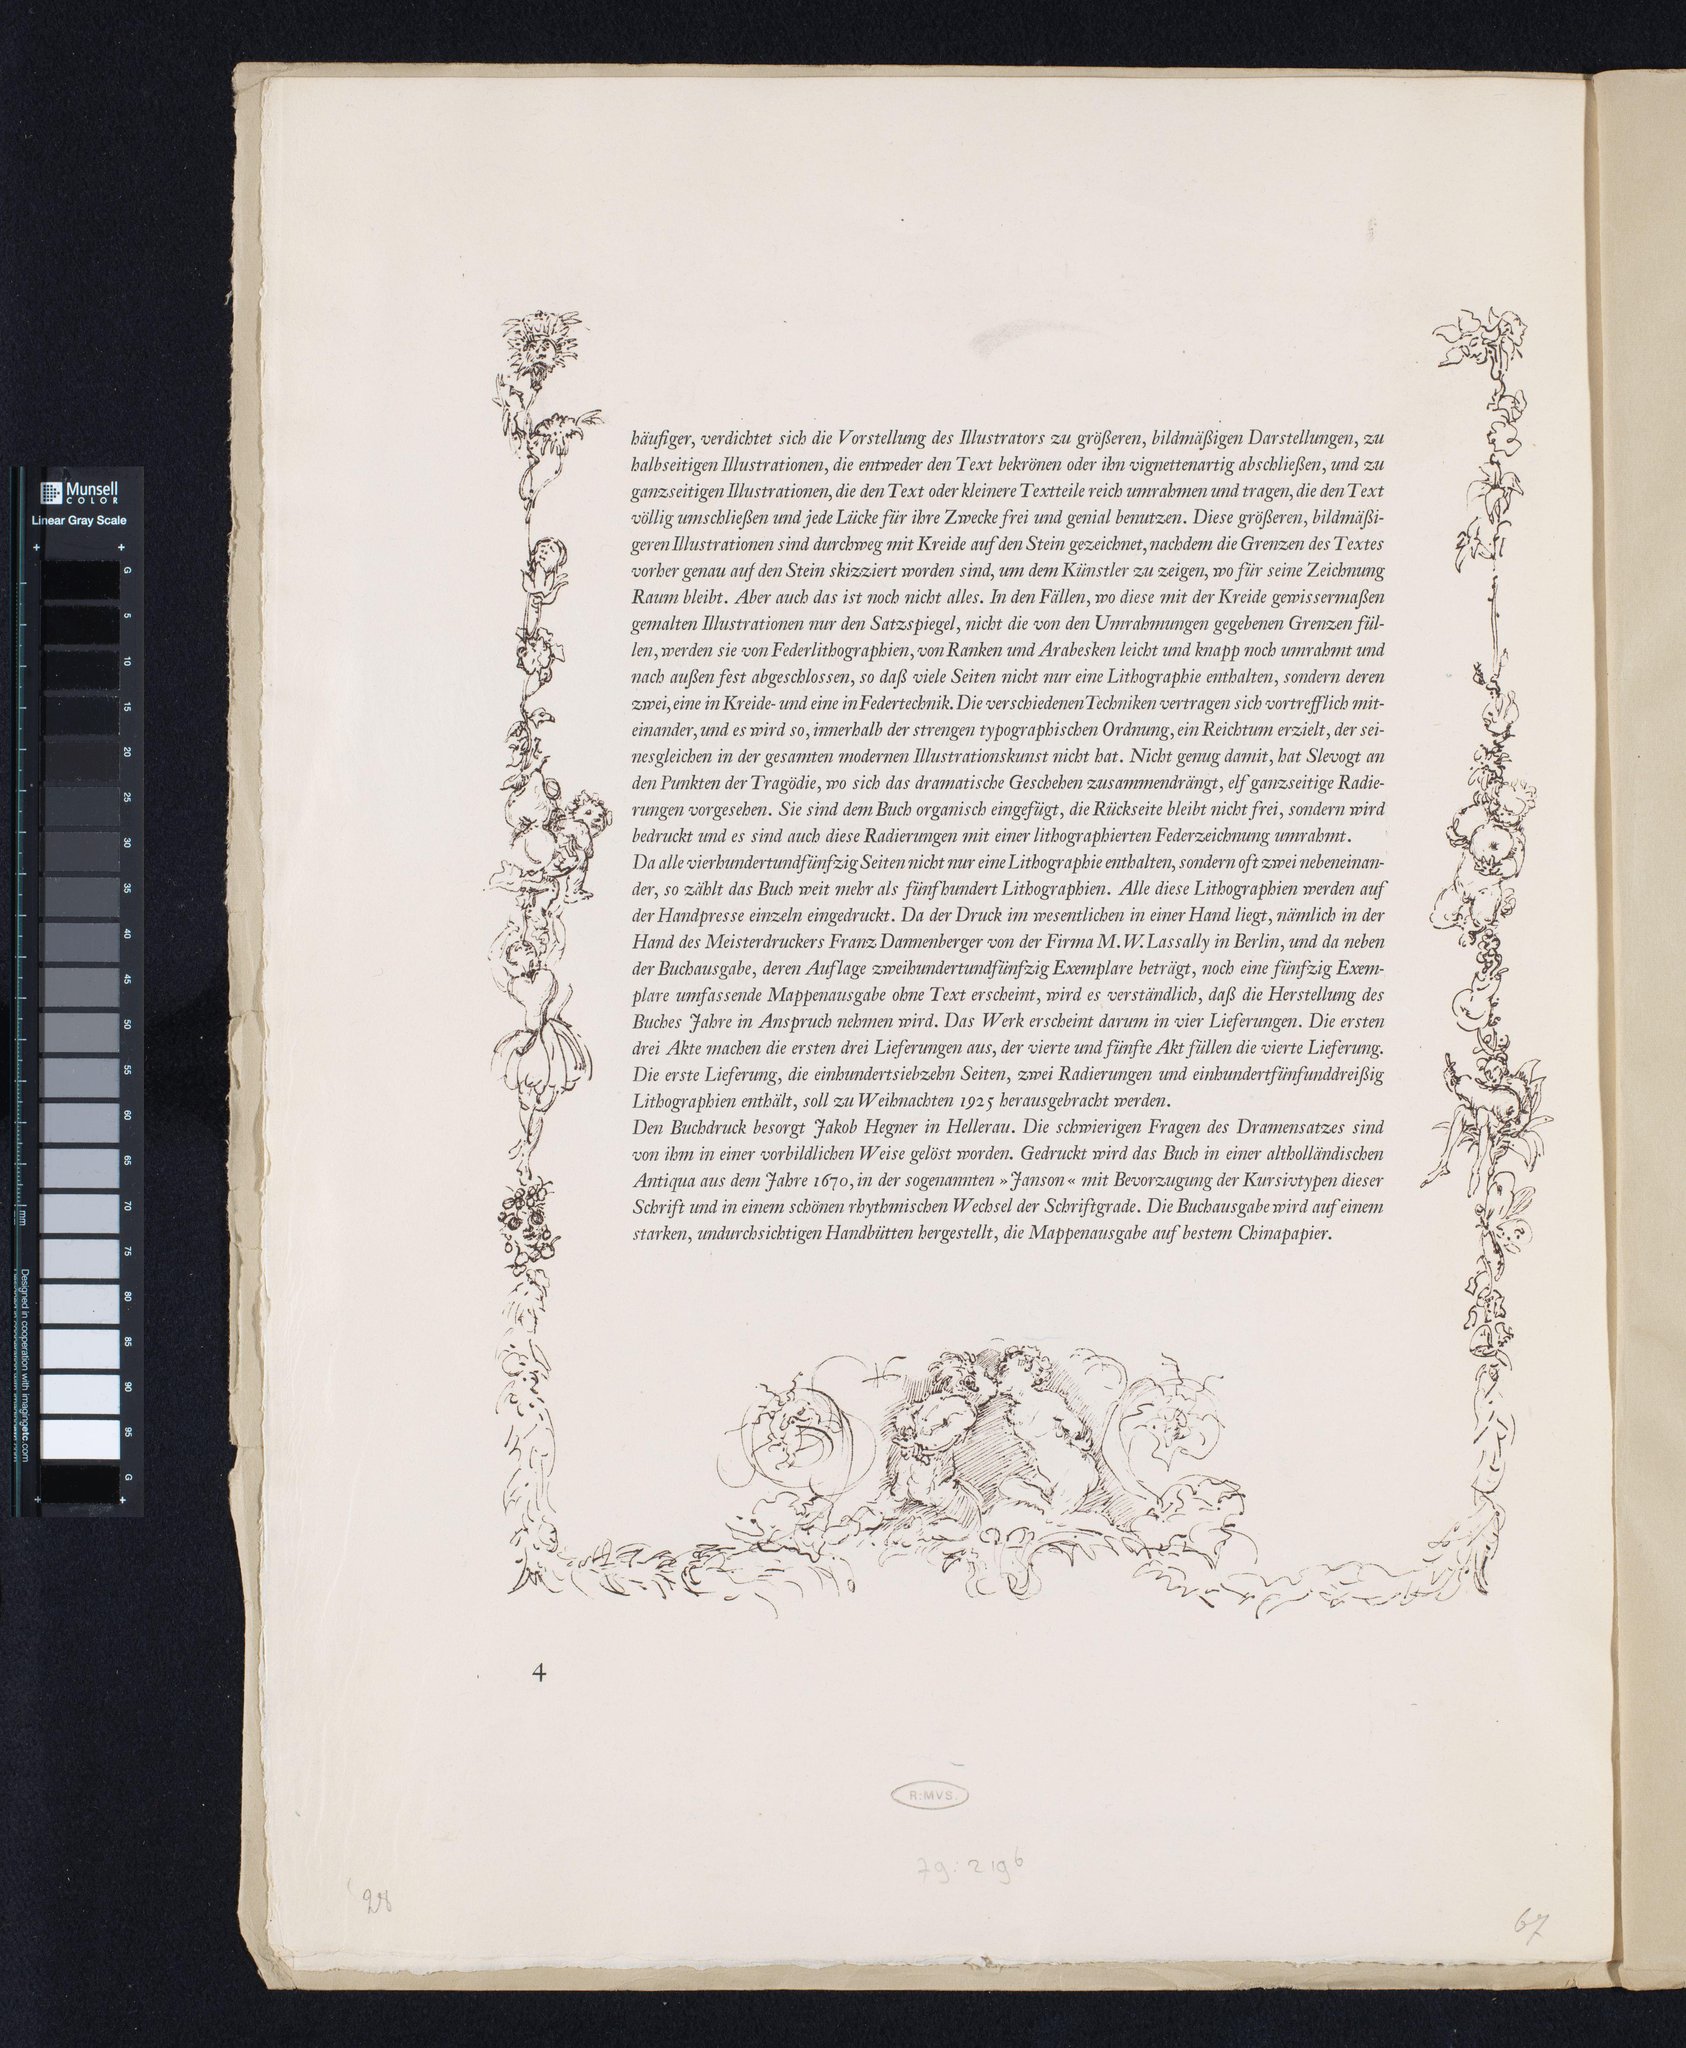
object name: print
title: Faust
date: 1925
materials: paper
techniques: lithograph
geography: berlin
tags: faust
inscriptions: collector's mark: Lugt 2228